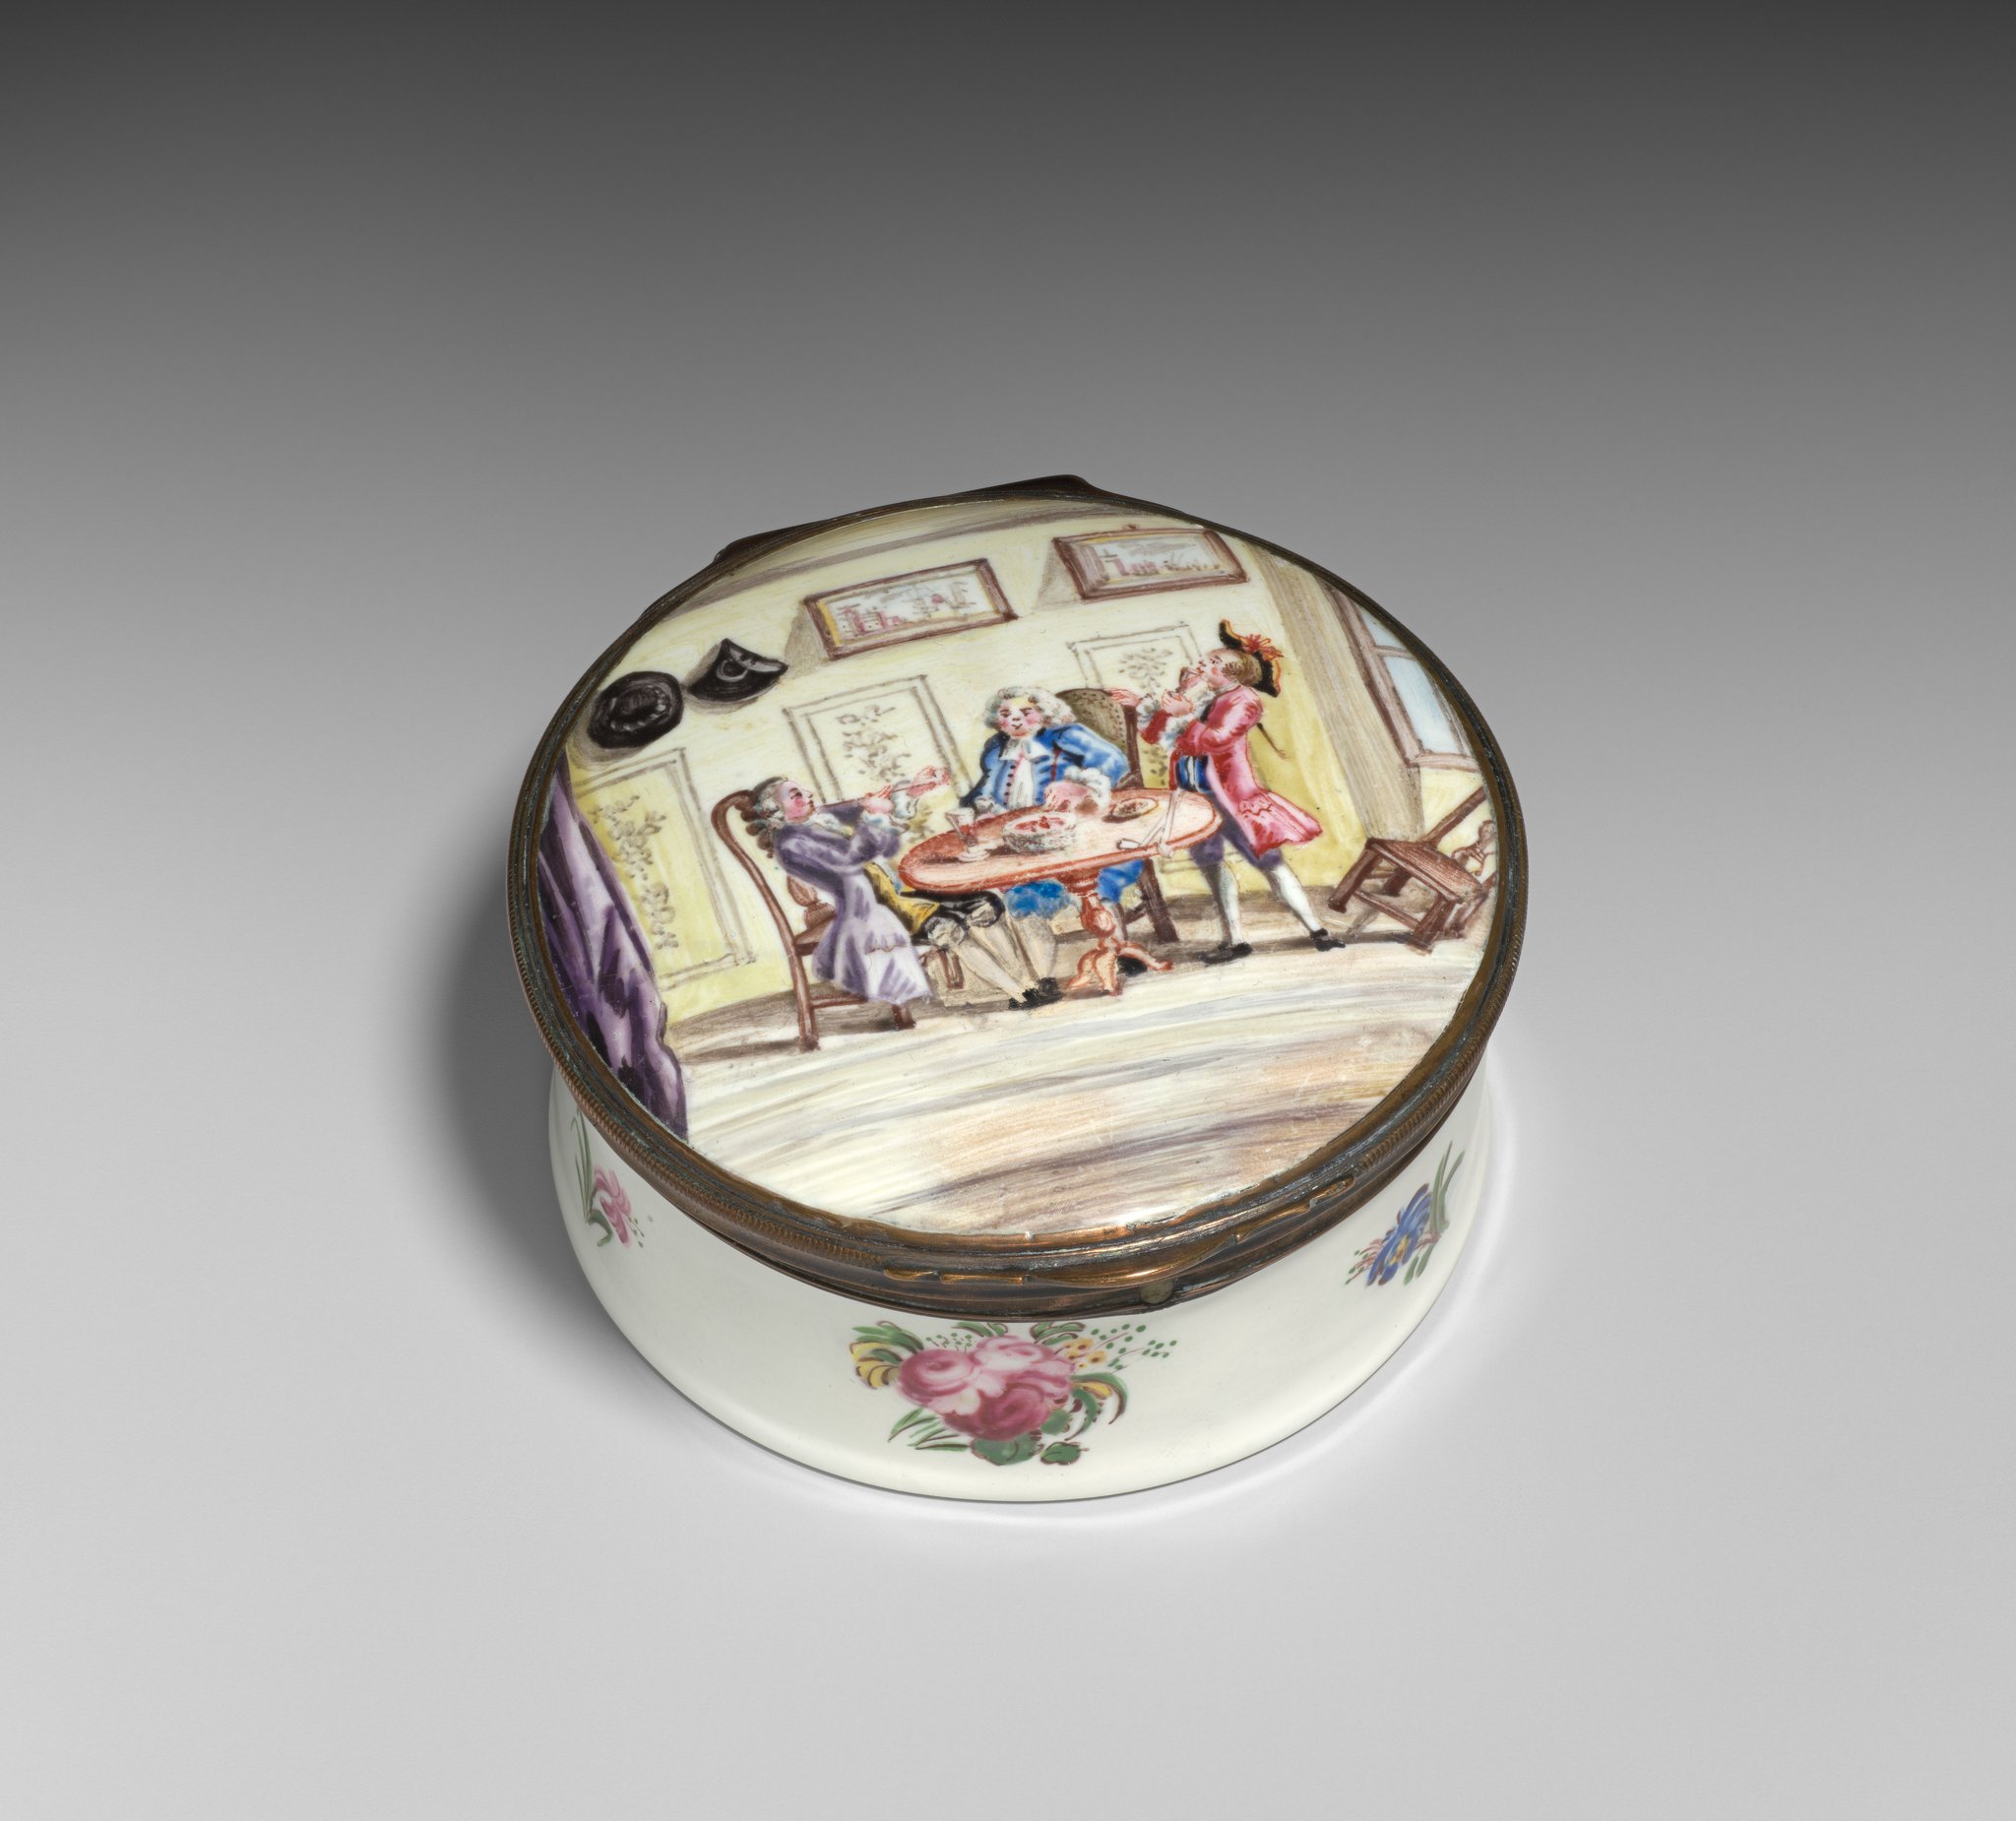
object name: snuffbox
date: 1770-1780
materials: copper, enamel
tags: men,drinking,tables